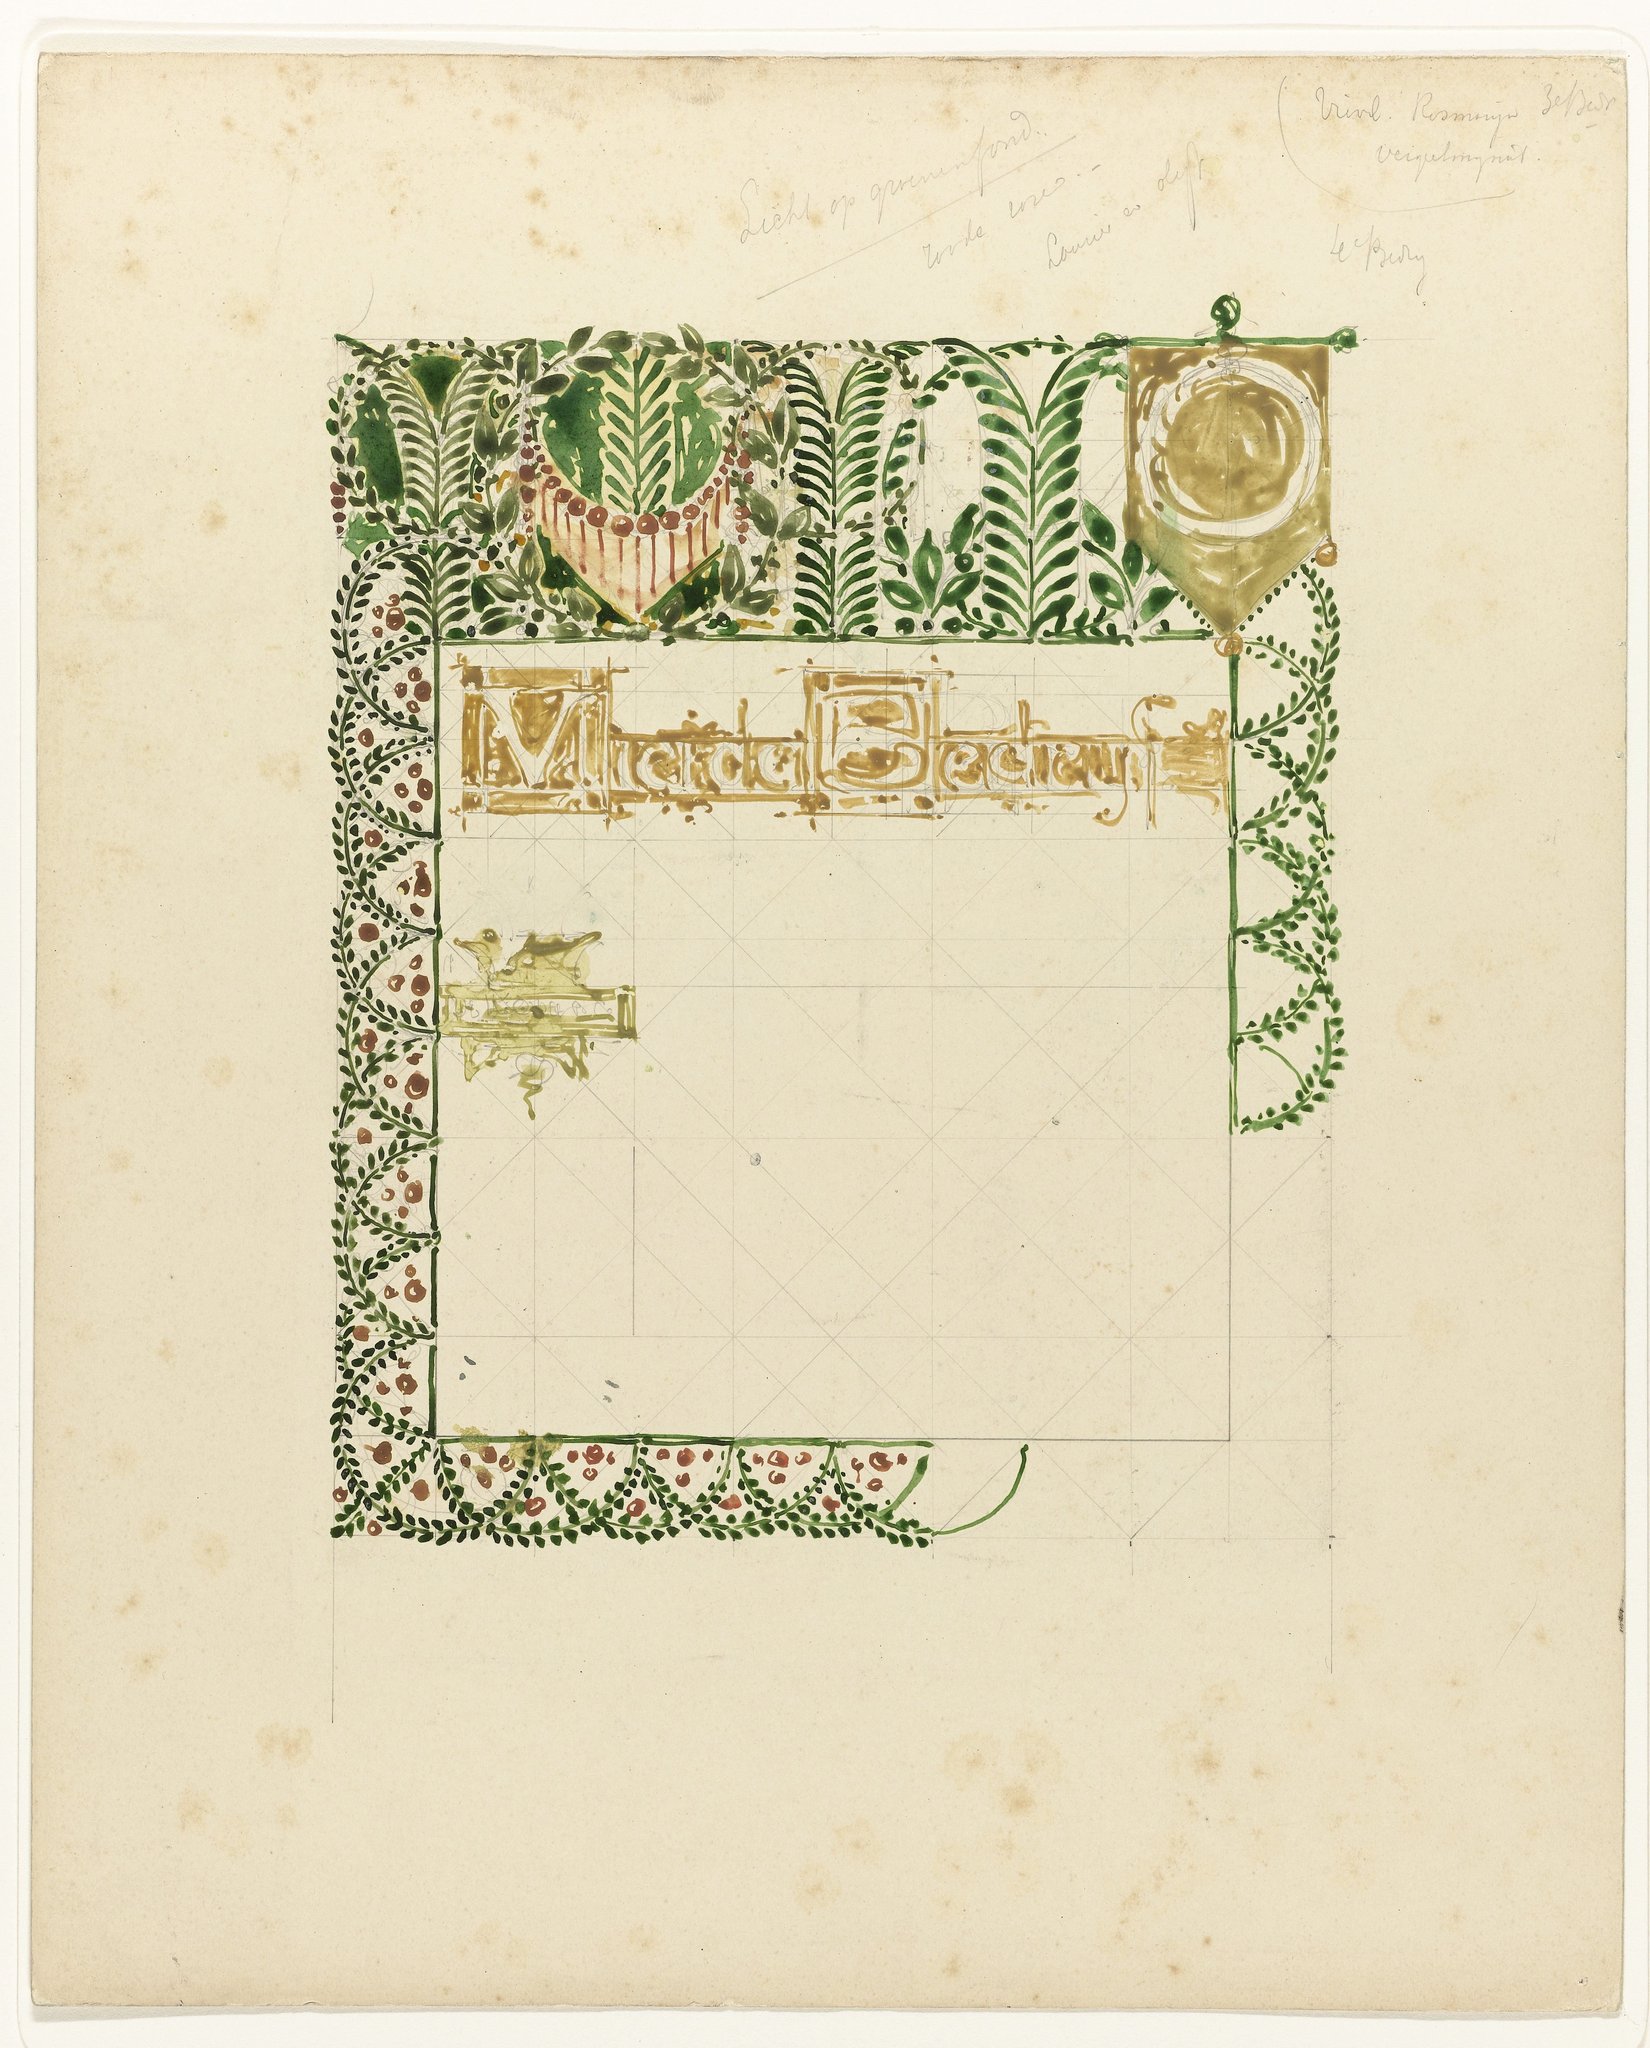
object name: drawing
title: Ontwerp voor tekst Vierde Bedrijf met ornamenten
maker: bernard willem wierink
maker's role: draughtsman, print maker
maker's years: 1856-1939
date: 1908-1937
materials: paper, pencil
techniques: brush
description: Titel "Vierde Bedrijf" in decoratieve rand met bladermotieven, rechts een banier. In map met 31 ontwerptekeningen en schetsen voor illustraties.